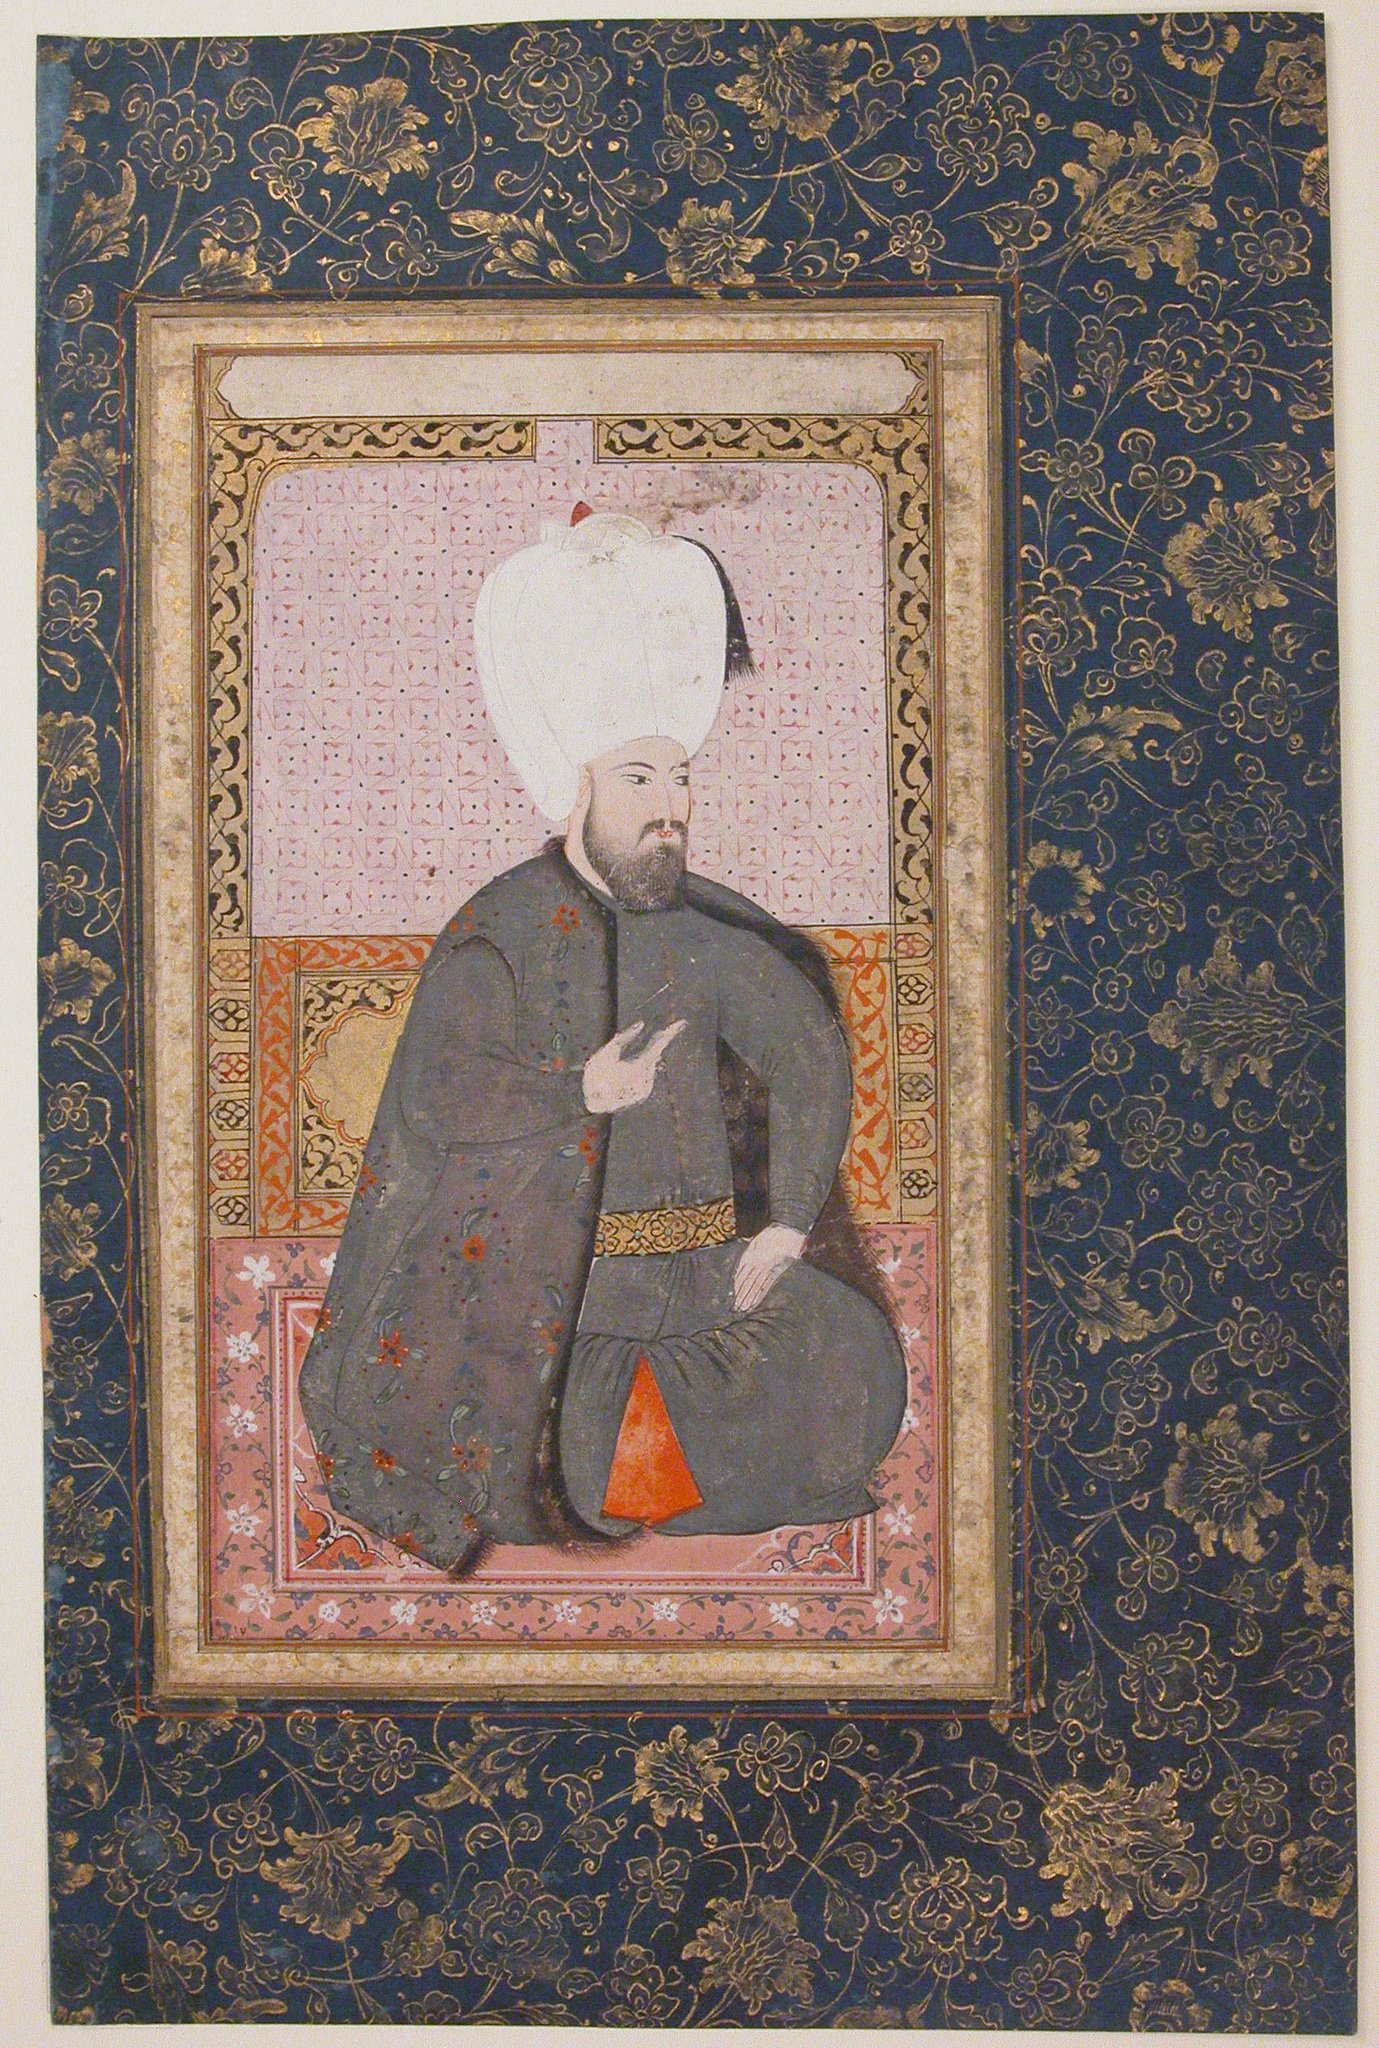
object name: illustrated album leaf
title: Portrait of Sultan Ahmet I (r. 1603–17)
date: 1601-1633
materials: gold, ink, paper, watercolor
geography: turkey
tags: men,portraits